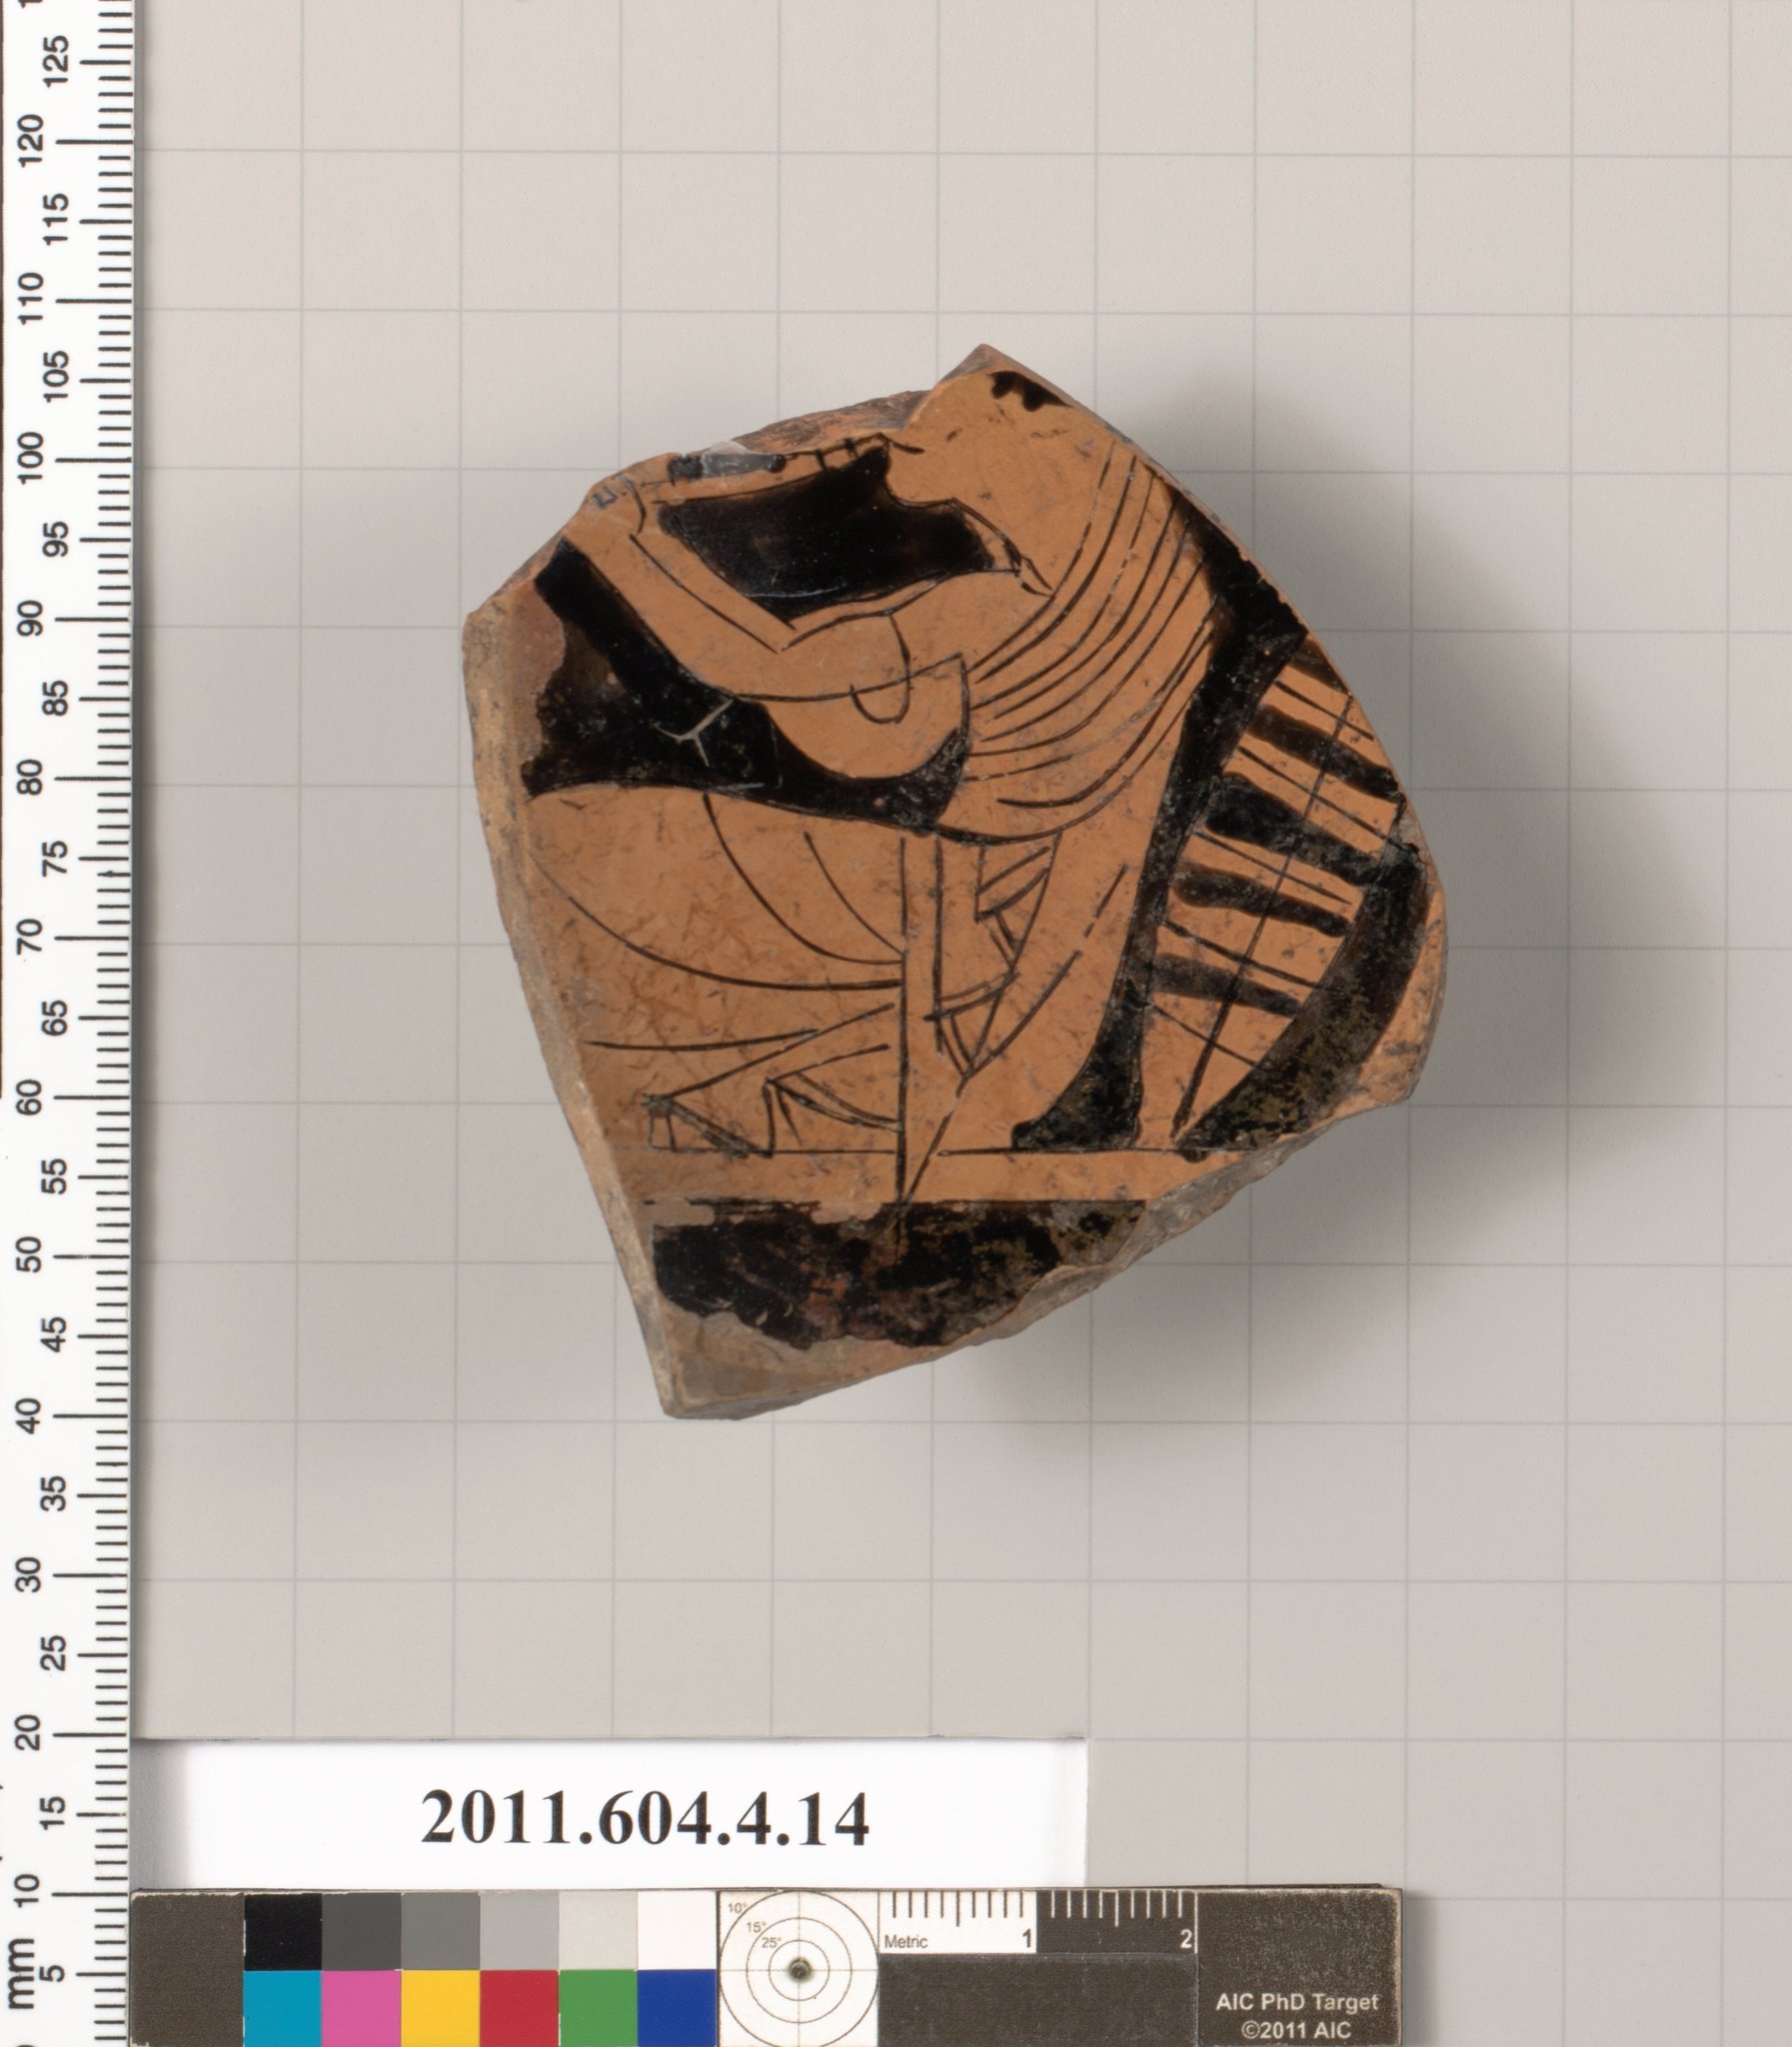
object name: kylix fragment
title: Terracotta fragment of a kylix (drinking cup)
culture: greek, attic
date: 500-476 BCE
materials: terracotta